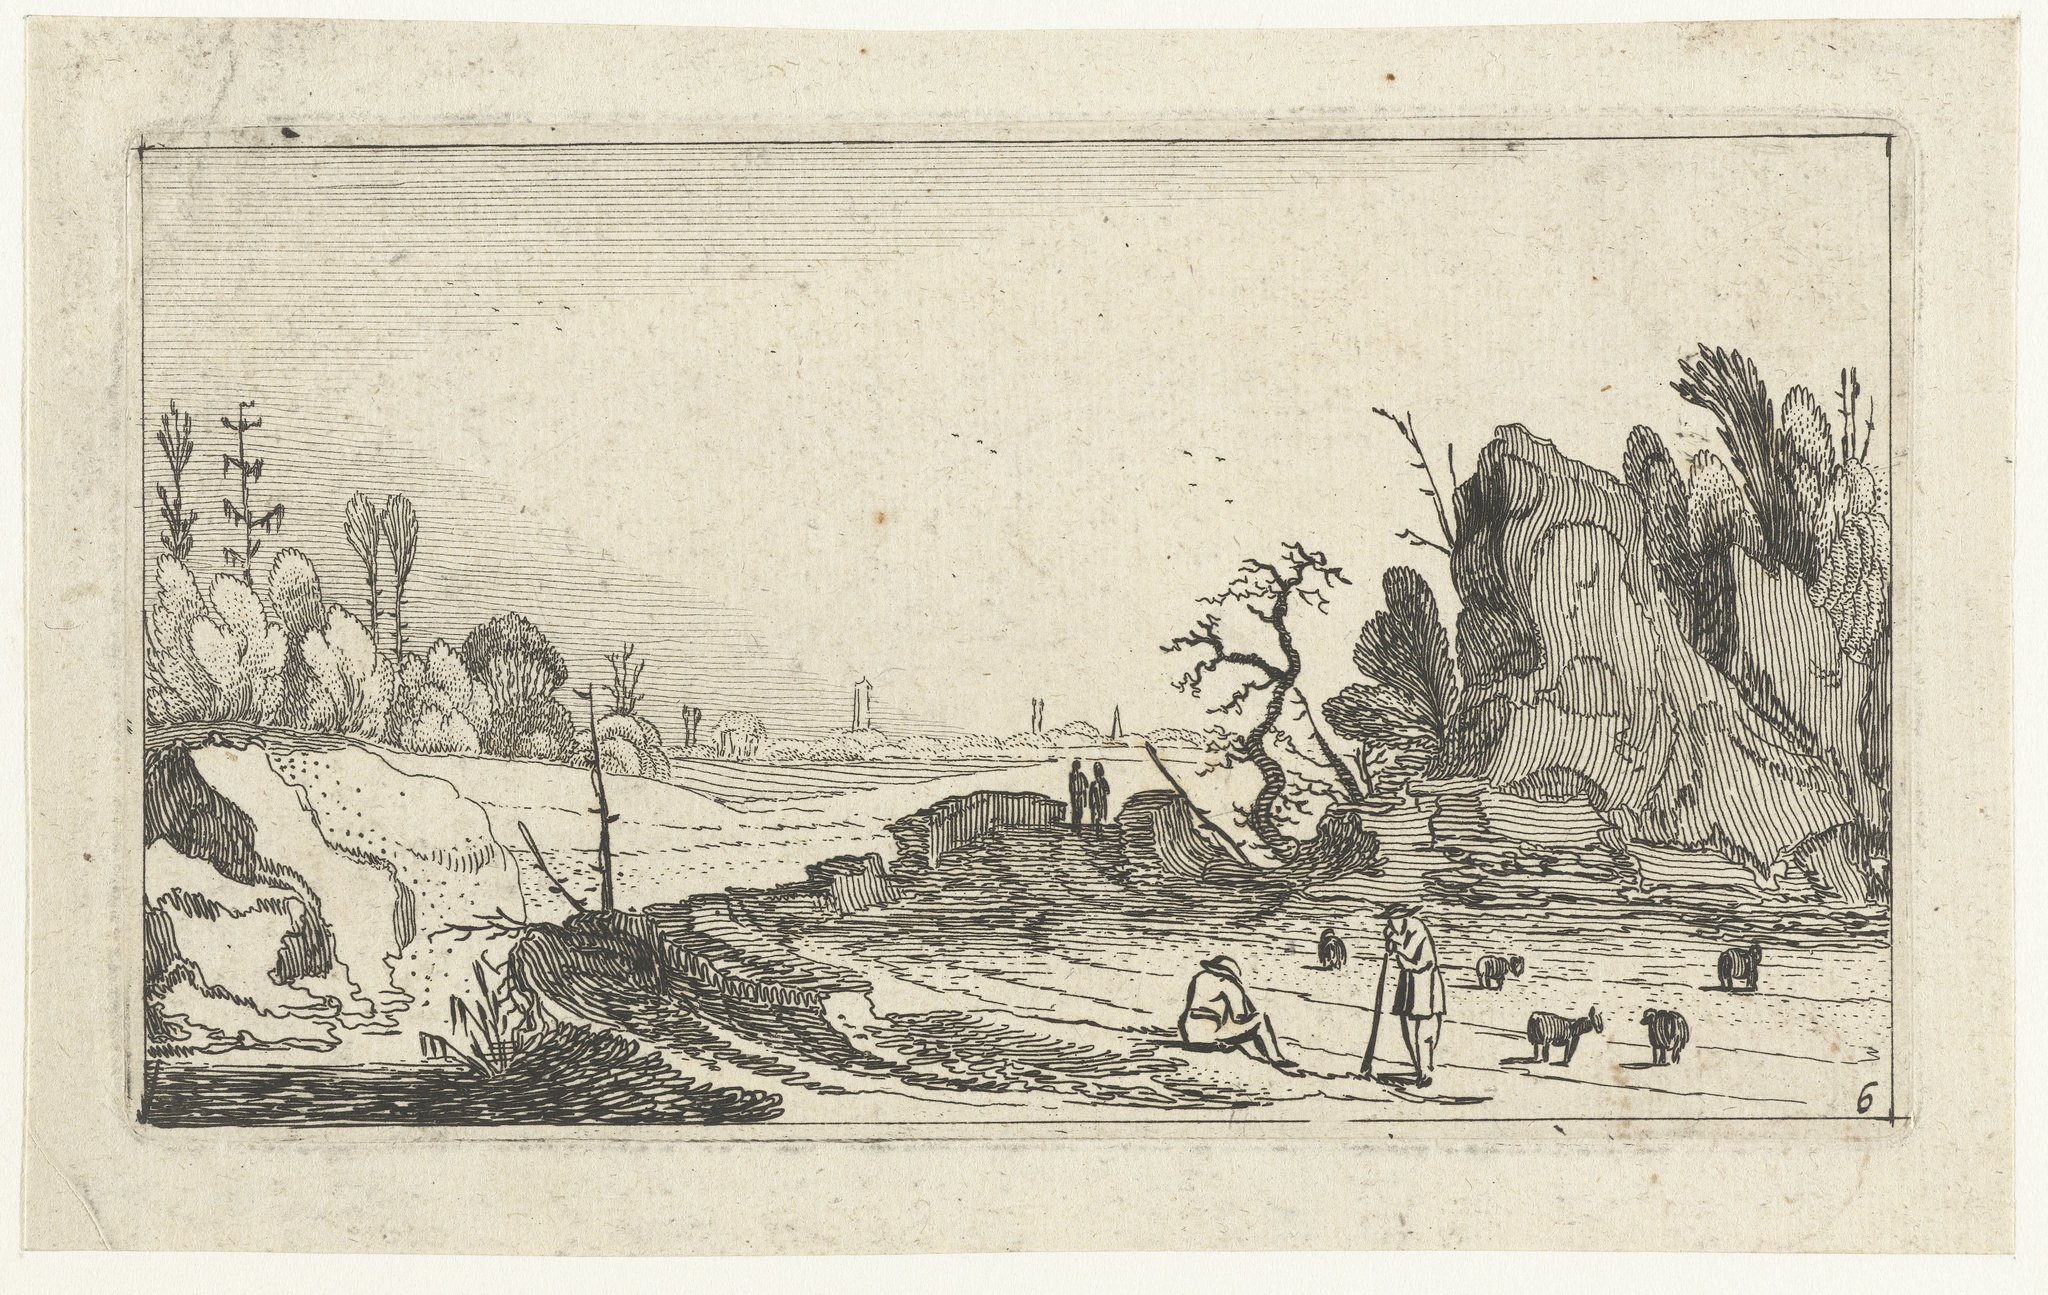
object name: print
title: Landschappen naar Esaias van de Velde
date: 1610-1650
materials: paper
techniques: etching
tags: herding, herdsman, herdswoman, shepherd, shepherdess, cowherd, etc., rocks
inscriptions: collector's mark: Lugt 2228a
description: Tekening van Esaias van de Velde in Cambridge, Massachusetts, zie Keyes 1984, cat.nr. D 154, pl. 17